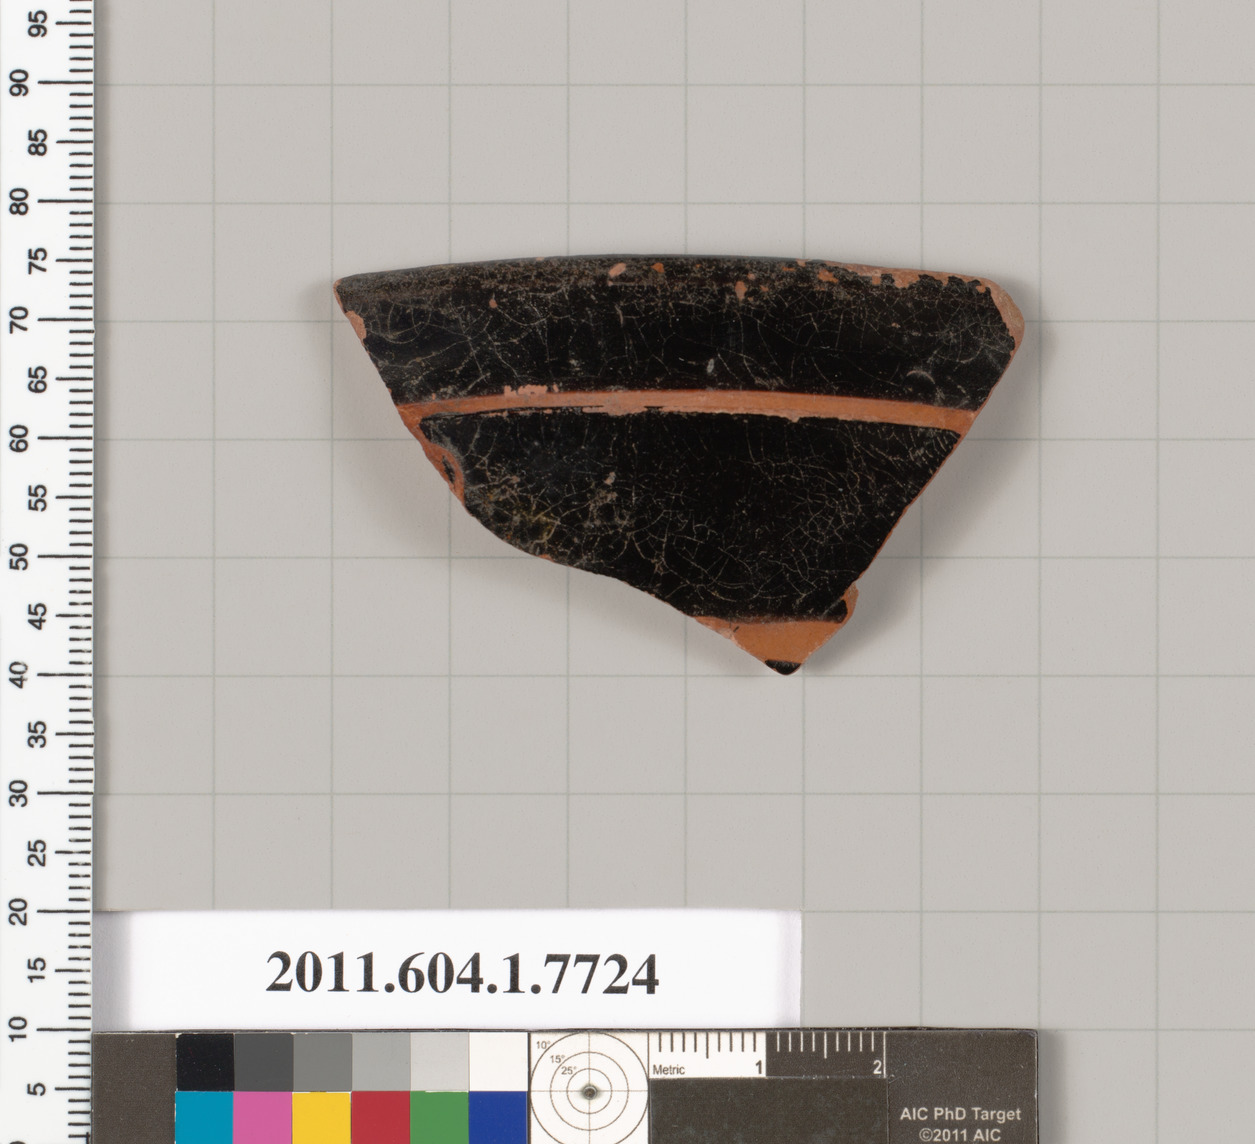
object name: kylix fragment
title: Terracotta rim fragment of a kylix (drinking cup)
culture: greek, attic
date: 460-450 BCE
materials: terracotta